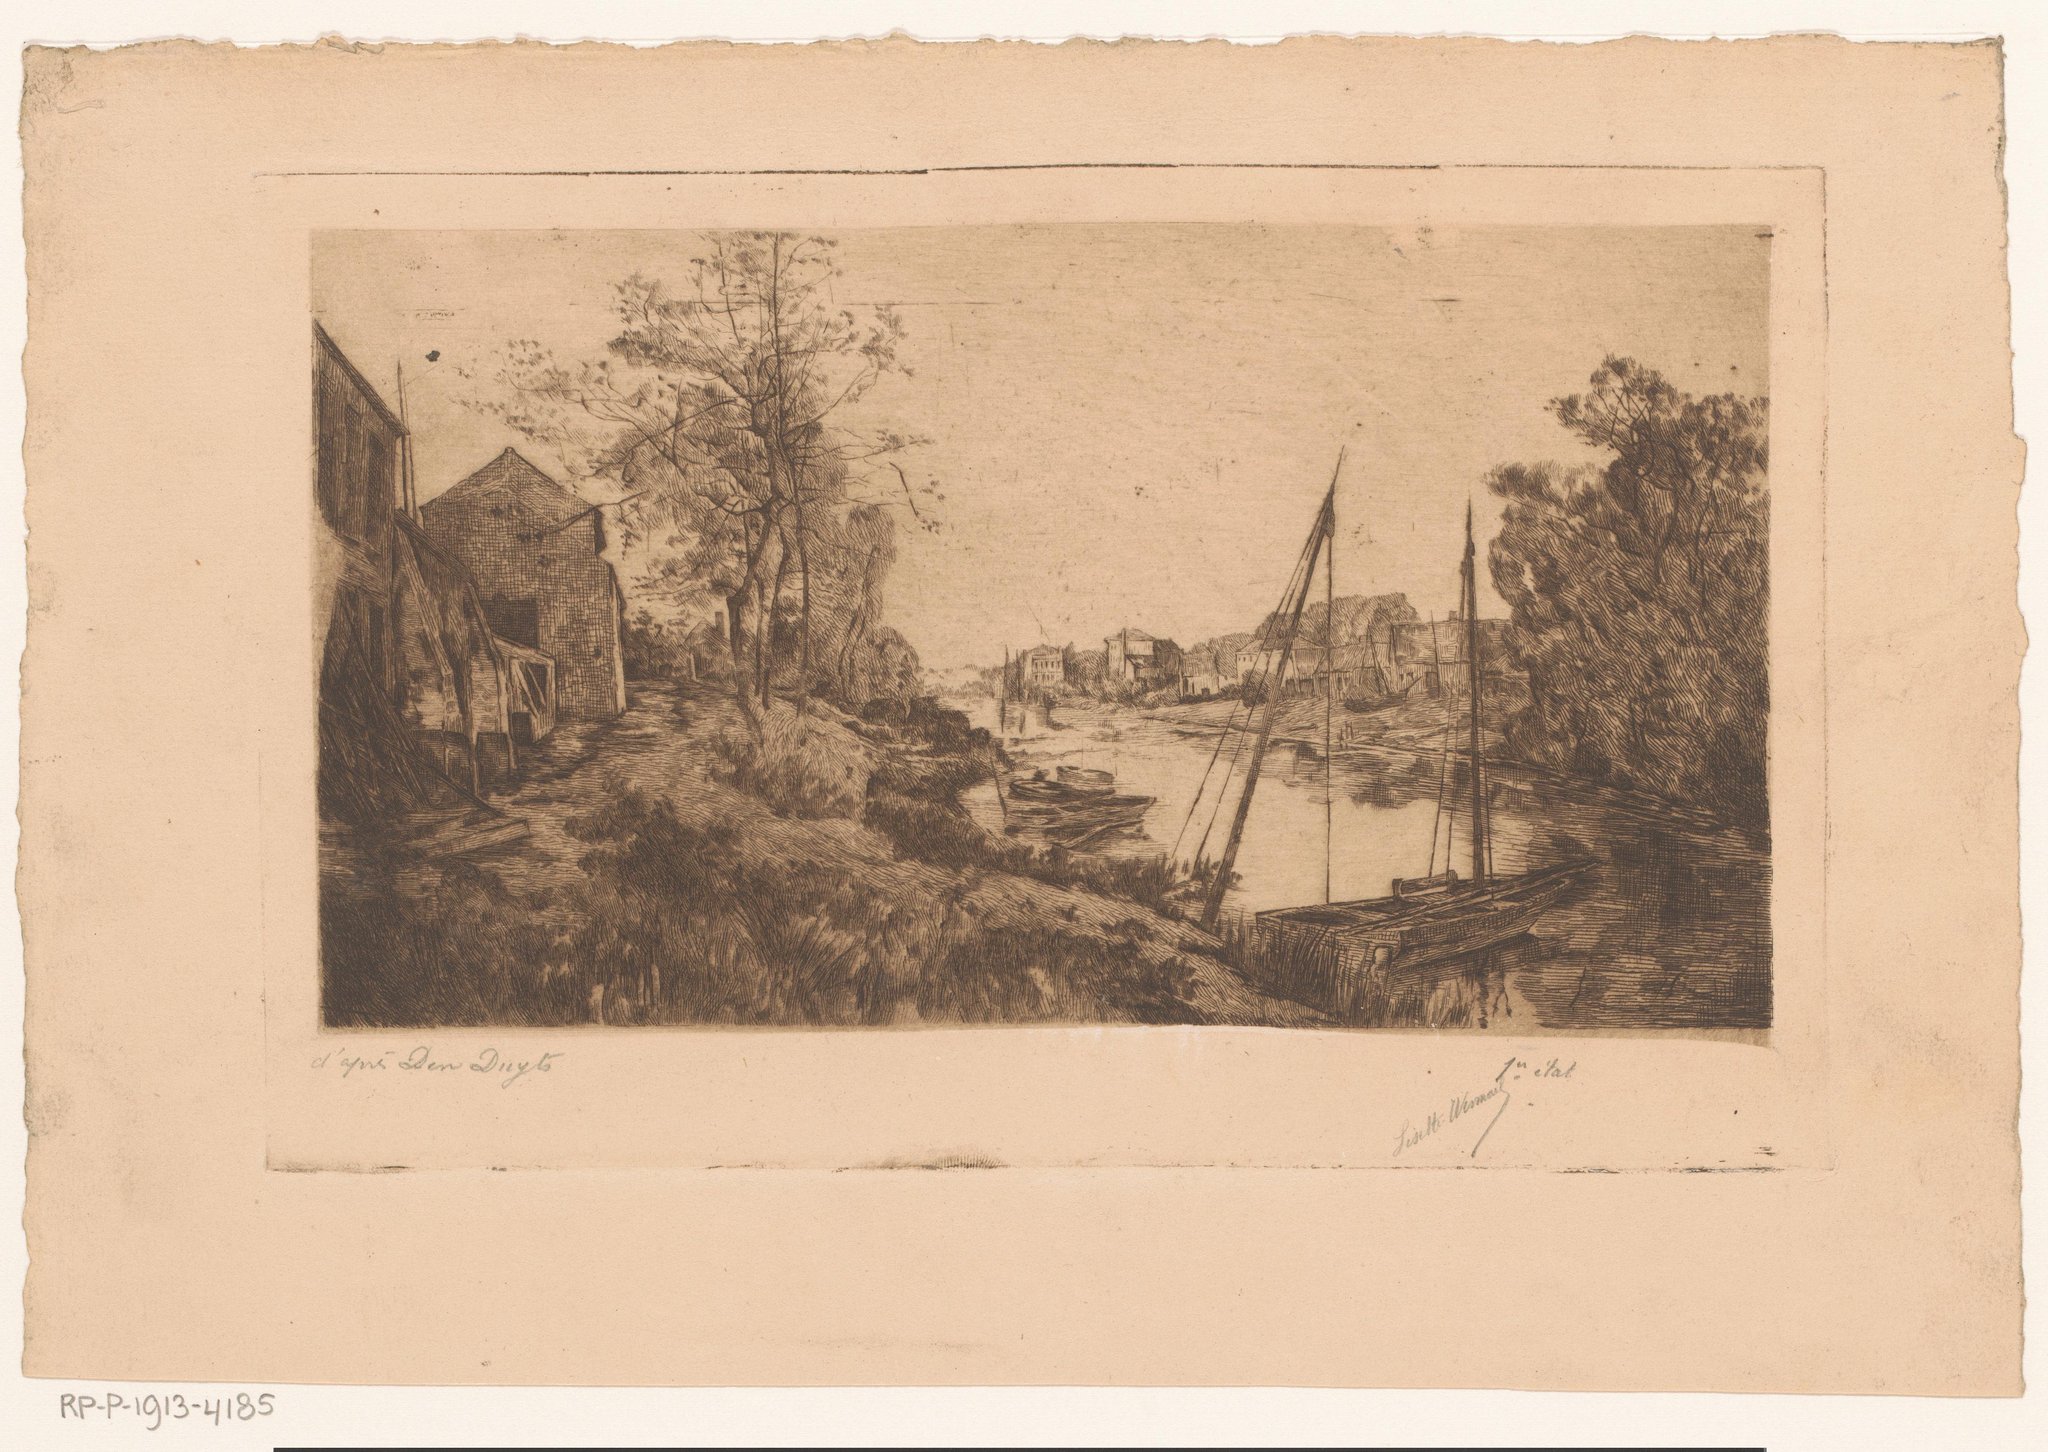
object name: print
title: Kanaal met aan weerszijden huizen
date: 1883-1913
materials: paper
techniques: etching, intaglio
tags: water course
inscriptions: watermark, collector's mark: Lugt 2228